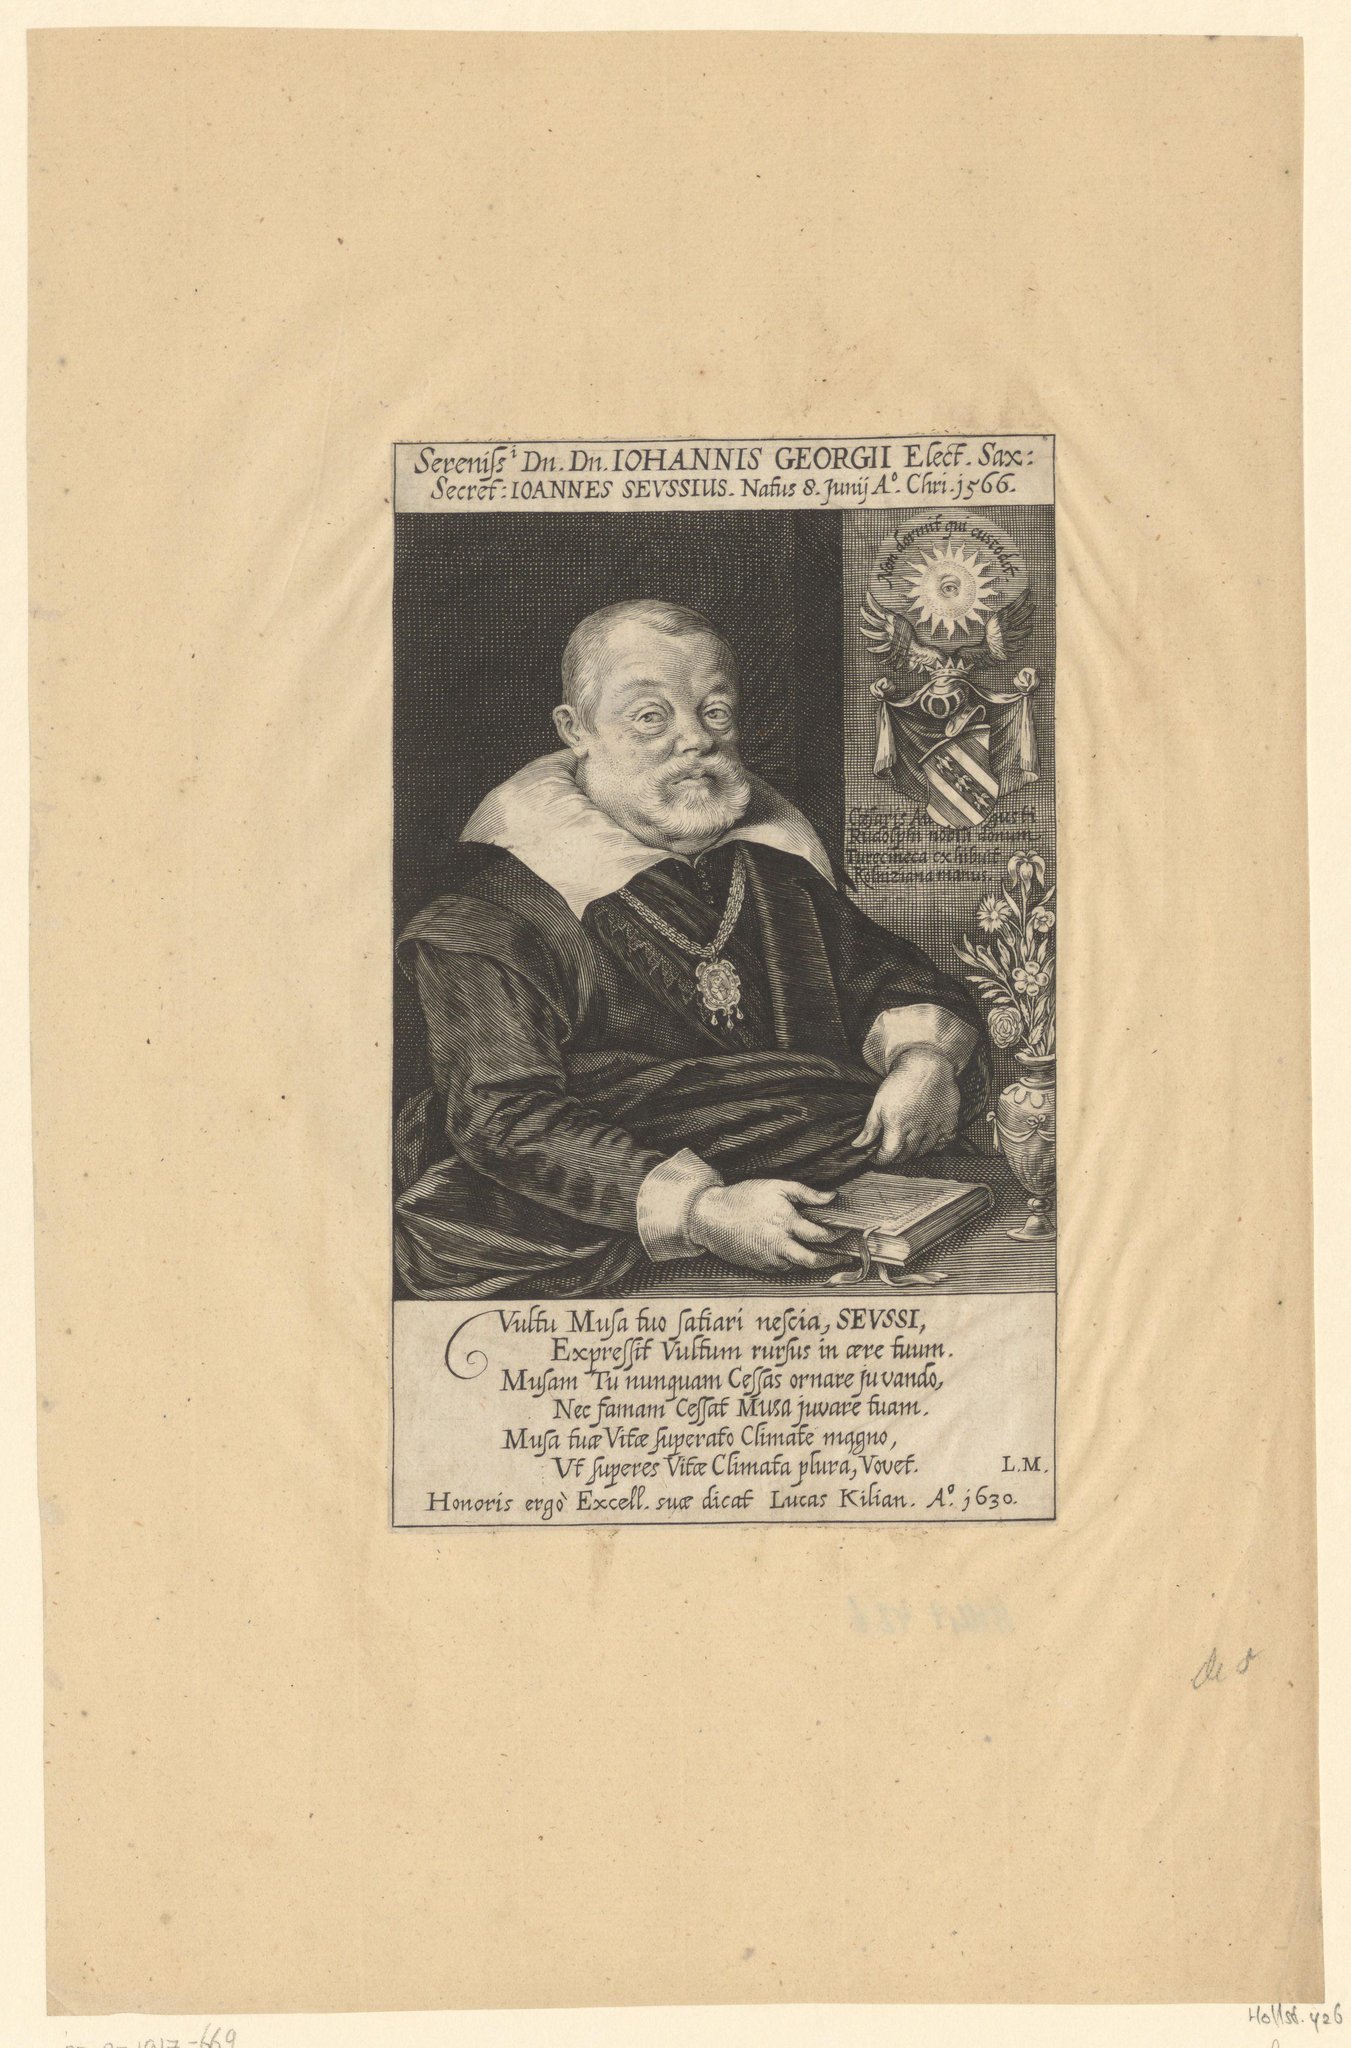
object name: print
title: Portret van Johannes Seusse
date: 1630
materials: paper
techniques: engraving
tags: historical persons, writer, poet, author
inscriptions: collector's mark: Lugt 2228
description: Tekst in het Latijn in de boven- en ondermarge.